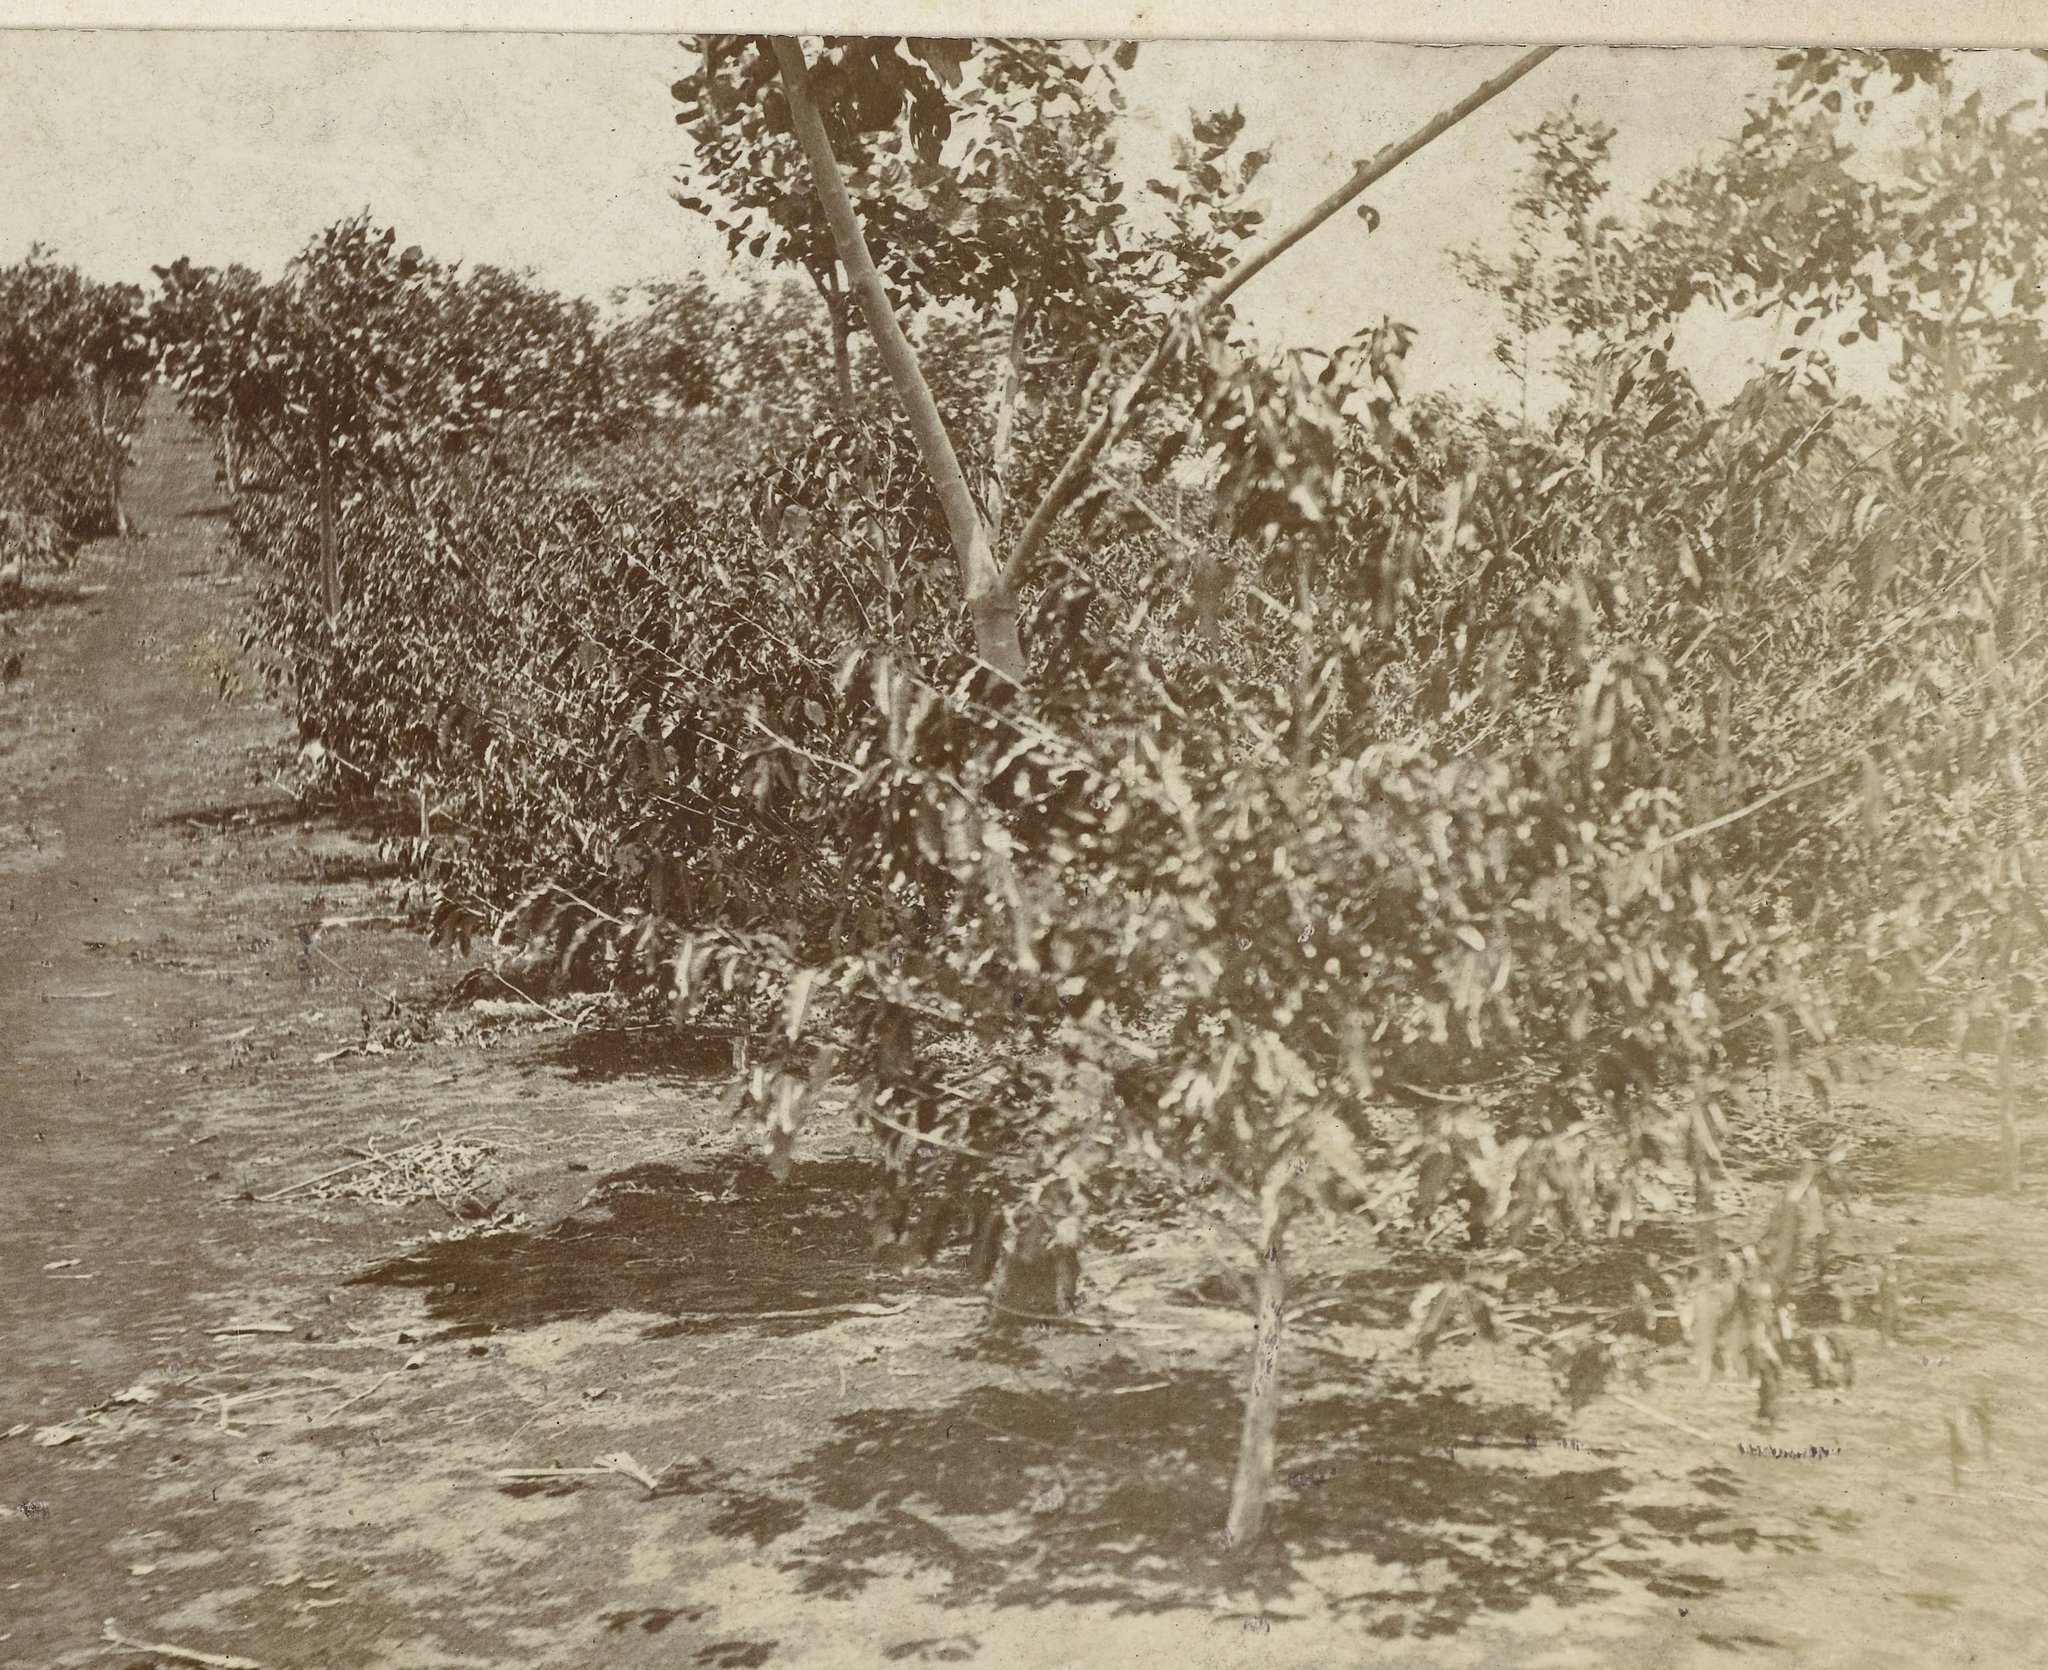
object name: photograph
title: Koffie veld op plantage Silo Sanen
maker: Anonymous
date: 1890-1910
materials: cardboard, paper, photographic support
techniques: gelatin silver print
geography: netherlands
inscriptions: caption: ‘Koffie planten te silo sanen’